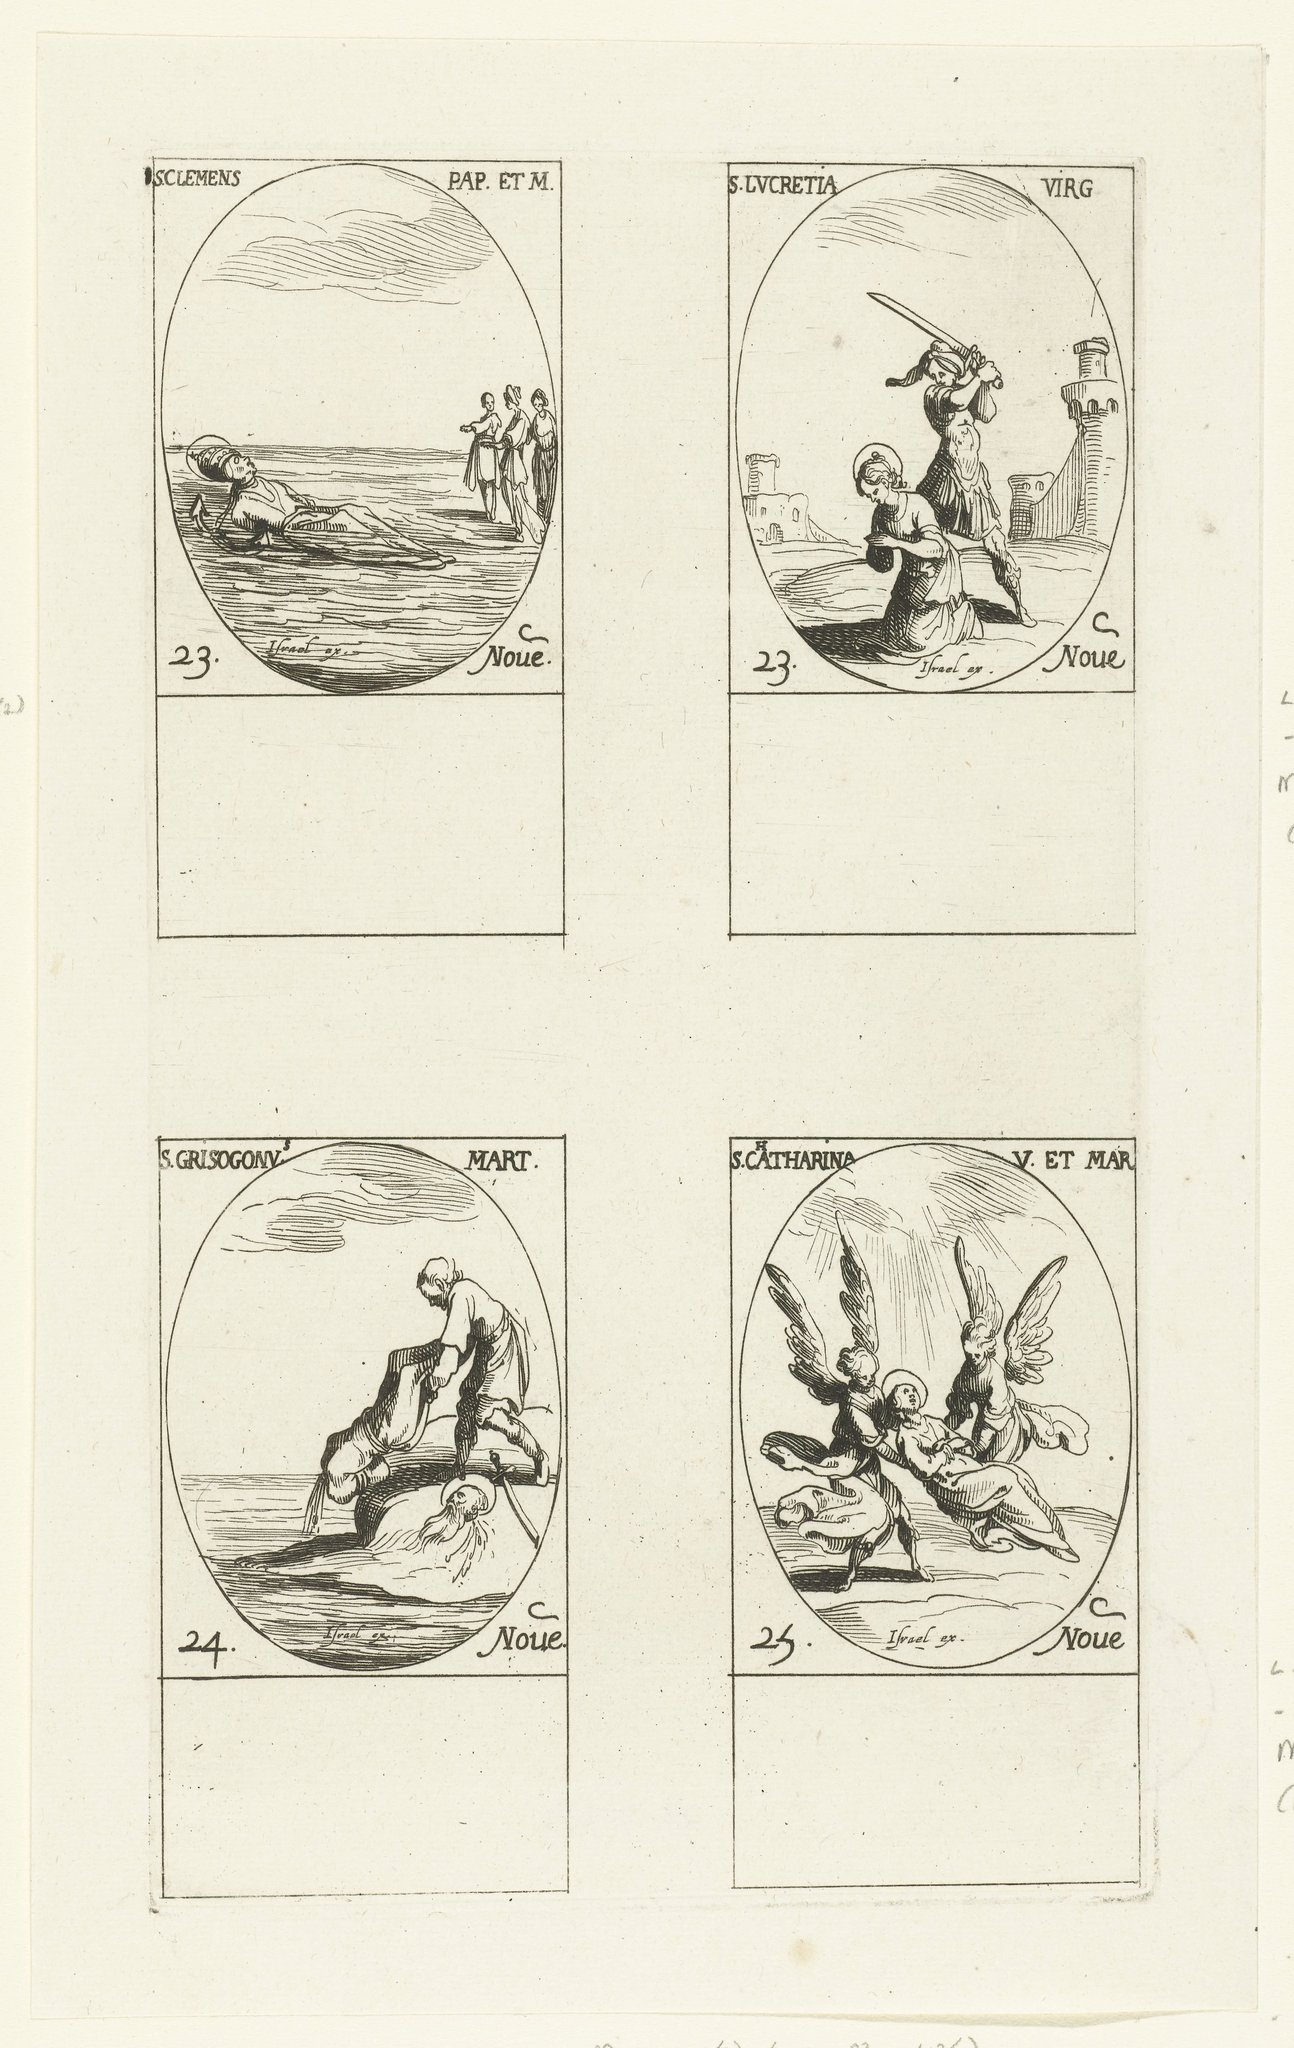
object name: print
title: Alle heiligen en de Christelijke feestdagen van het jaar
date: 1632-1636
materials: paper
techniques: etching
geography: paris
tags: female saints (with name) - finding, transportation of relics of female saint, male saints (with name), female saints (with name), st. clement is thrown off a cliff (or from a boat) into the sea with an anchor (or a millstone) tied to his neck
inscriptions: collector's mark: Lugt 240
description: Blad met vier ovale voorstellingen, elk met opschrift en datum in het Latijn: linksboven de Heilige Clemens I die met een anker om zijn nek verdrinkt, rechtsboven de Heilige Lucretia van Mérida die onthoofd wordt, linksonder de Heilige Chrysogonus van Aquileia die na onthoofd te zijn in het water wordt gegooid, rechtsonder de Heilige Catharina van Alexandrië die door engelen weggedragen wordt. Deze prent is onderdeel van een serie prenten met voorstellingen van de heiligen en de christelijke feestdagen van het jaar. Er zijn steeds vier scènes van één plaat op één blad gedrukt. Inclusief bijbehorend titelblad en frontispice gaat het in totaal om 124 platen (490 voorstellingen). De drie platen met de laatste 12 scènes (de veranderlijke christelijke feestdagen) zijn in de derde staat versneden tot 12 kleine plaatjes, en met een apart titelblad uitgegeven.